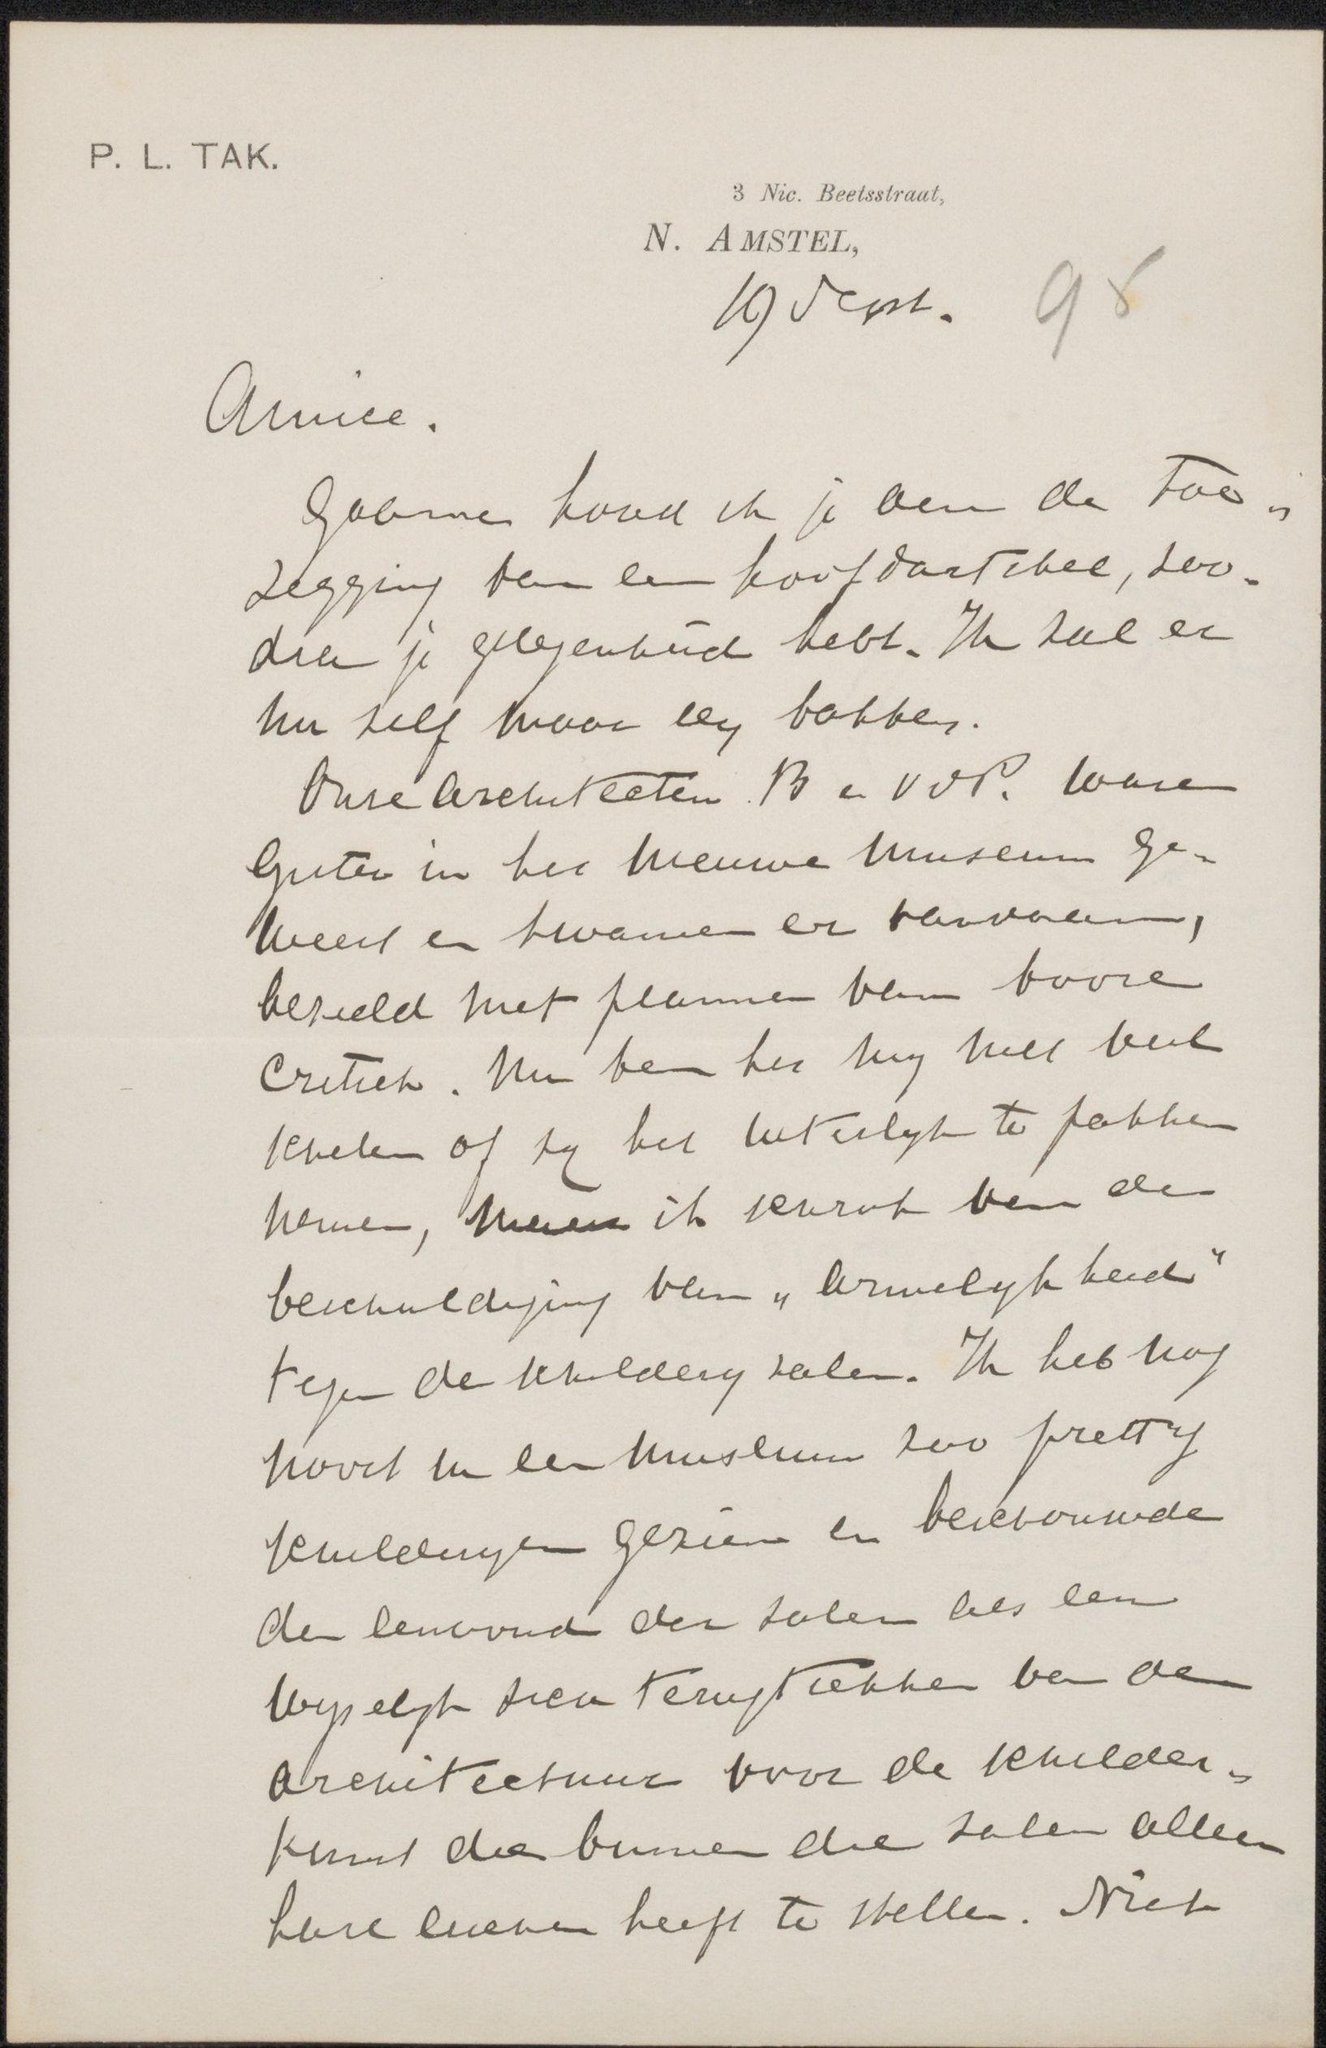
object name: letter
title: Brief aan Jan Veth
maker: pieter lodewijk tak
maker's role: politician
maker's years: 1848-1907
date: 1874-1907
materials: ink, paper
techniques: pen, printing, writing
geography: nieuwer-amstel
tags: dordrecht, amsterdam, painter, print maker, draughtsman, designer, jan veth, the hague, hendrik petrus berlage, jan ernst van der pek, painting (including book-illumination, miniature-painting), architecture, exhibition ~ art, printed matter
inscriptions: collector's mark: ‘RPK’, watermark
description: Brief gedateerd 19 Sept. door schrijver, met toevoeging 95 in latere hand.